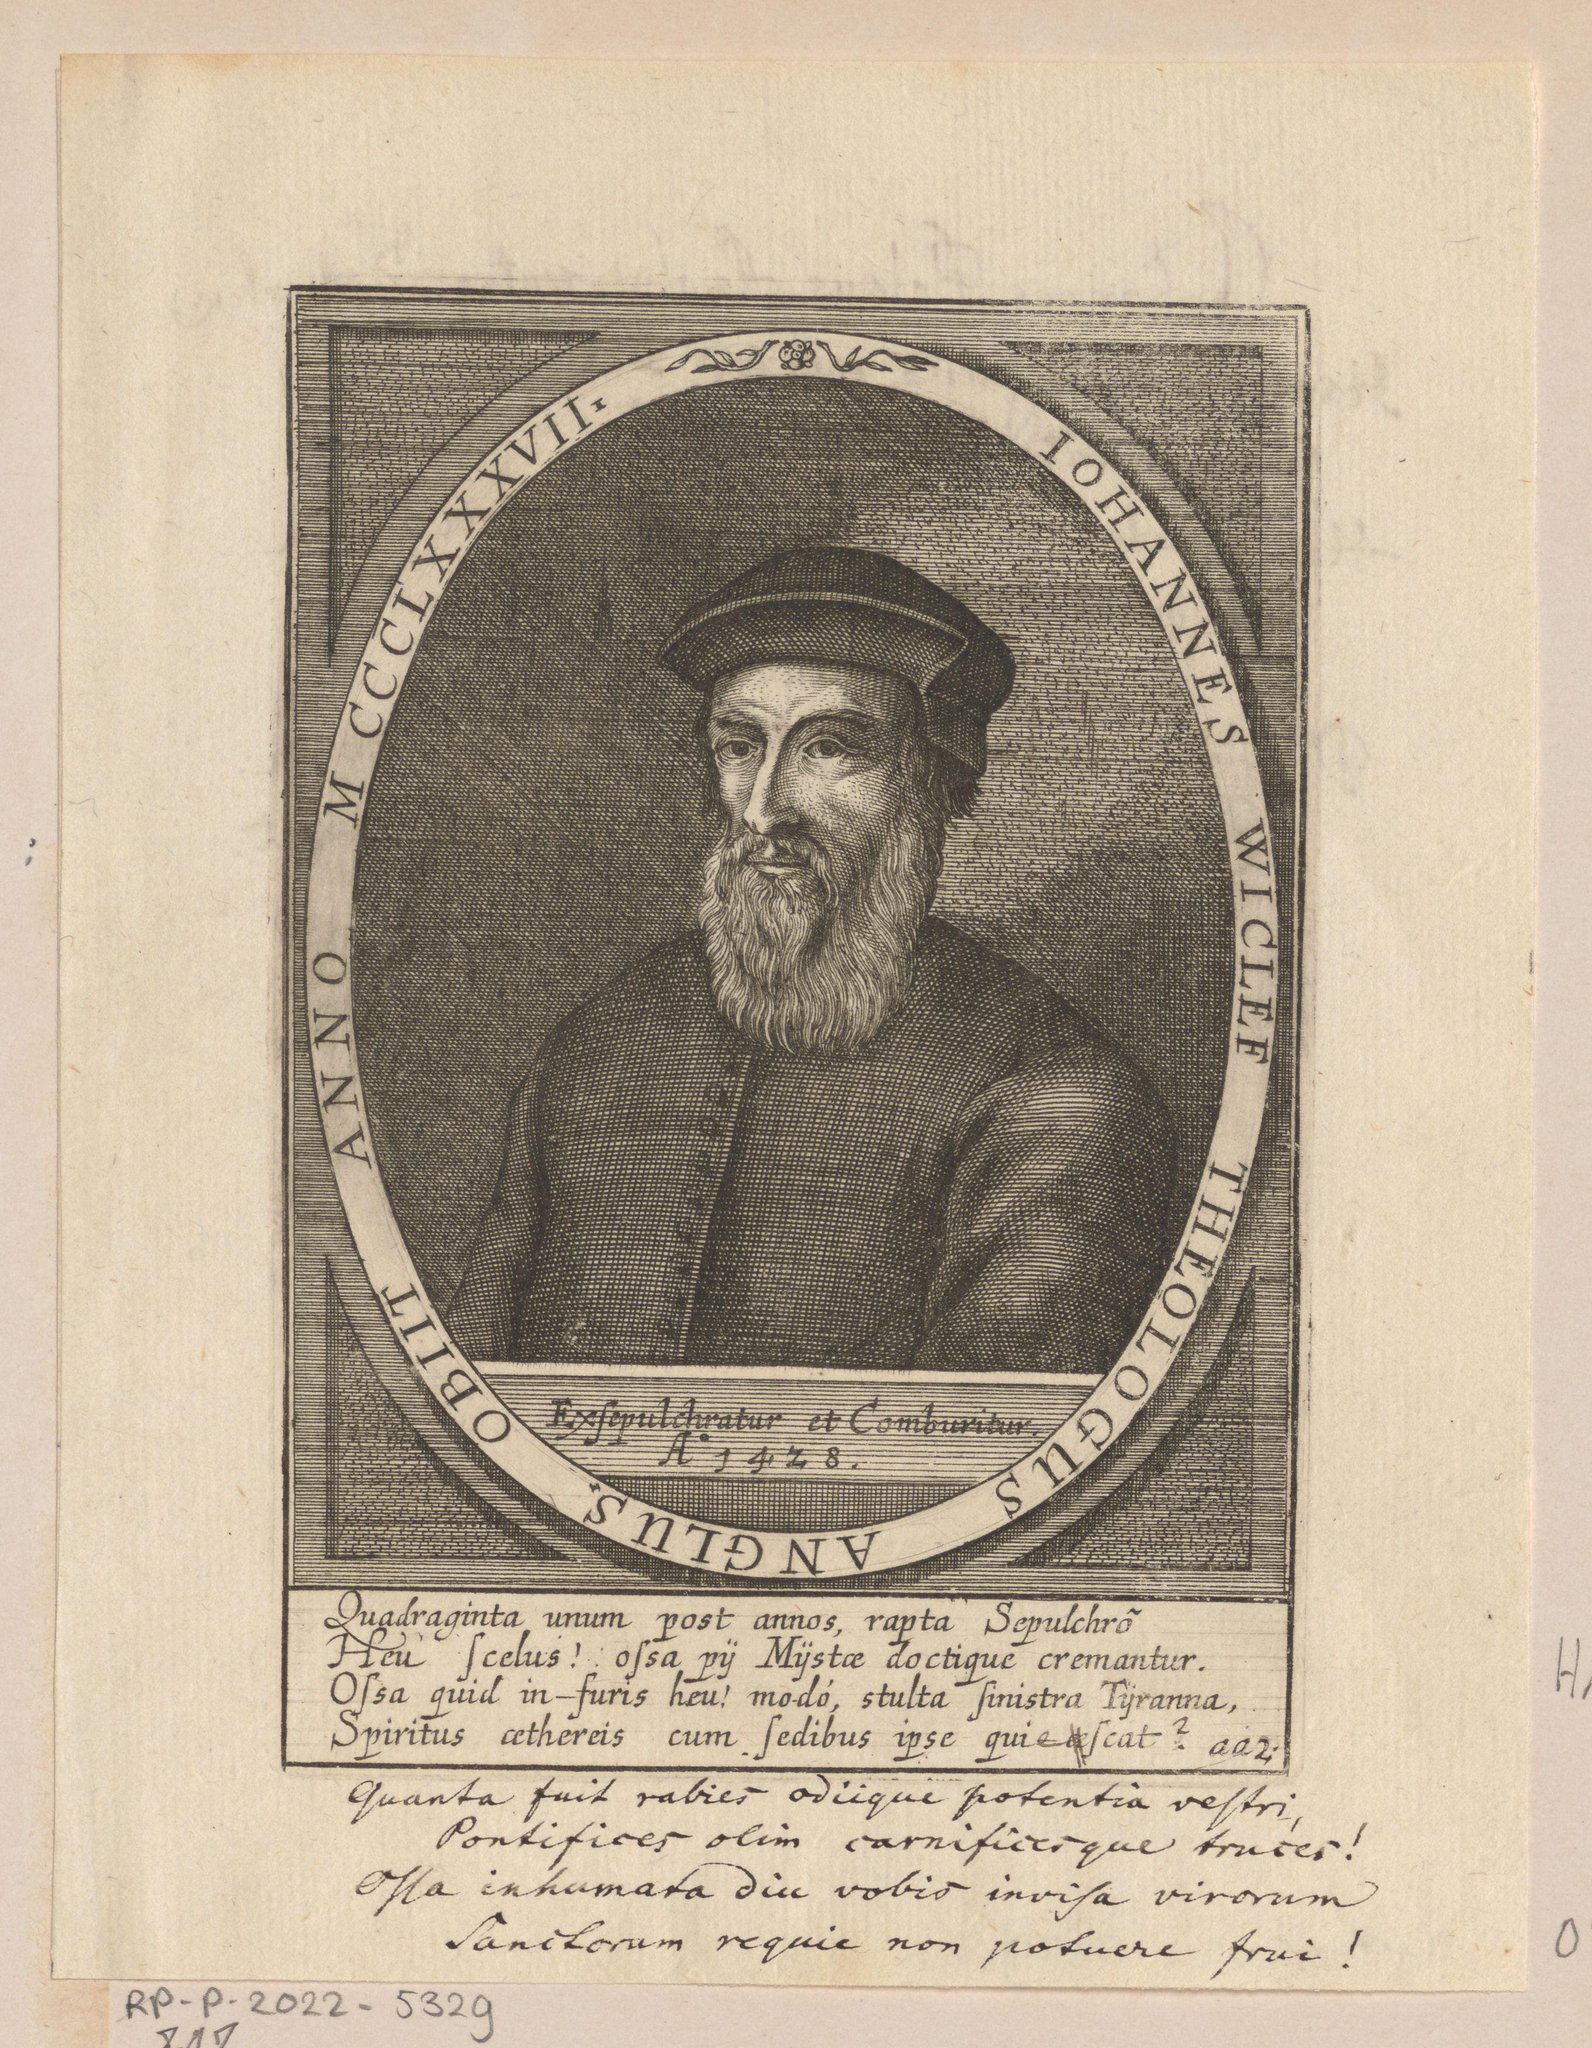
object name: print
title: Portret van John Wyclif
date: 1650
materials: paper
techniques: engraving, etching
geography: frankfurt am main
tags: theologian, historical persons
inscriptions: inscription: ‘Johannes Balaeus. Anglus. natus Zudvolck./ Haecest BALAEI facies generosa Britanni,/ Cujus dicuntus Bibliotheca libri./ Haec fraudes aperit multas, scelera impia multa/ Papae, quem dicit requitiae esse patrem/ Aliud in Illum/ Plurima LUTHERUS patefecit, PLATINA multa:/ Quaedam VERGERIUS cuncta BALAEUS babet.’, inscription: ‘Quanta fuit rabiet ad[...]que potentia vestri,/ pontifices [..]im carnificerque [...]rutes! Oha inhumata di[...] volio invisa vivorum/ sanctorum requie non profuere trui!’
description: Prent uit: Boissard, Jean Jacques. Bibliotheca Chalcographica Continuatio secunda Iconum Virorum Illustrium. Frankfurt am Main: Johann Ammon, 1650.